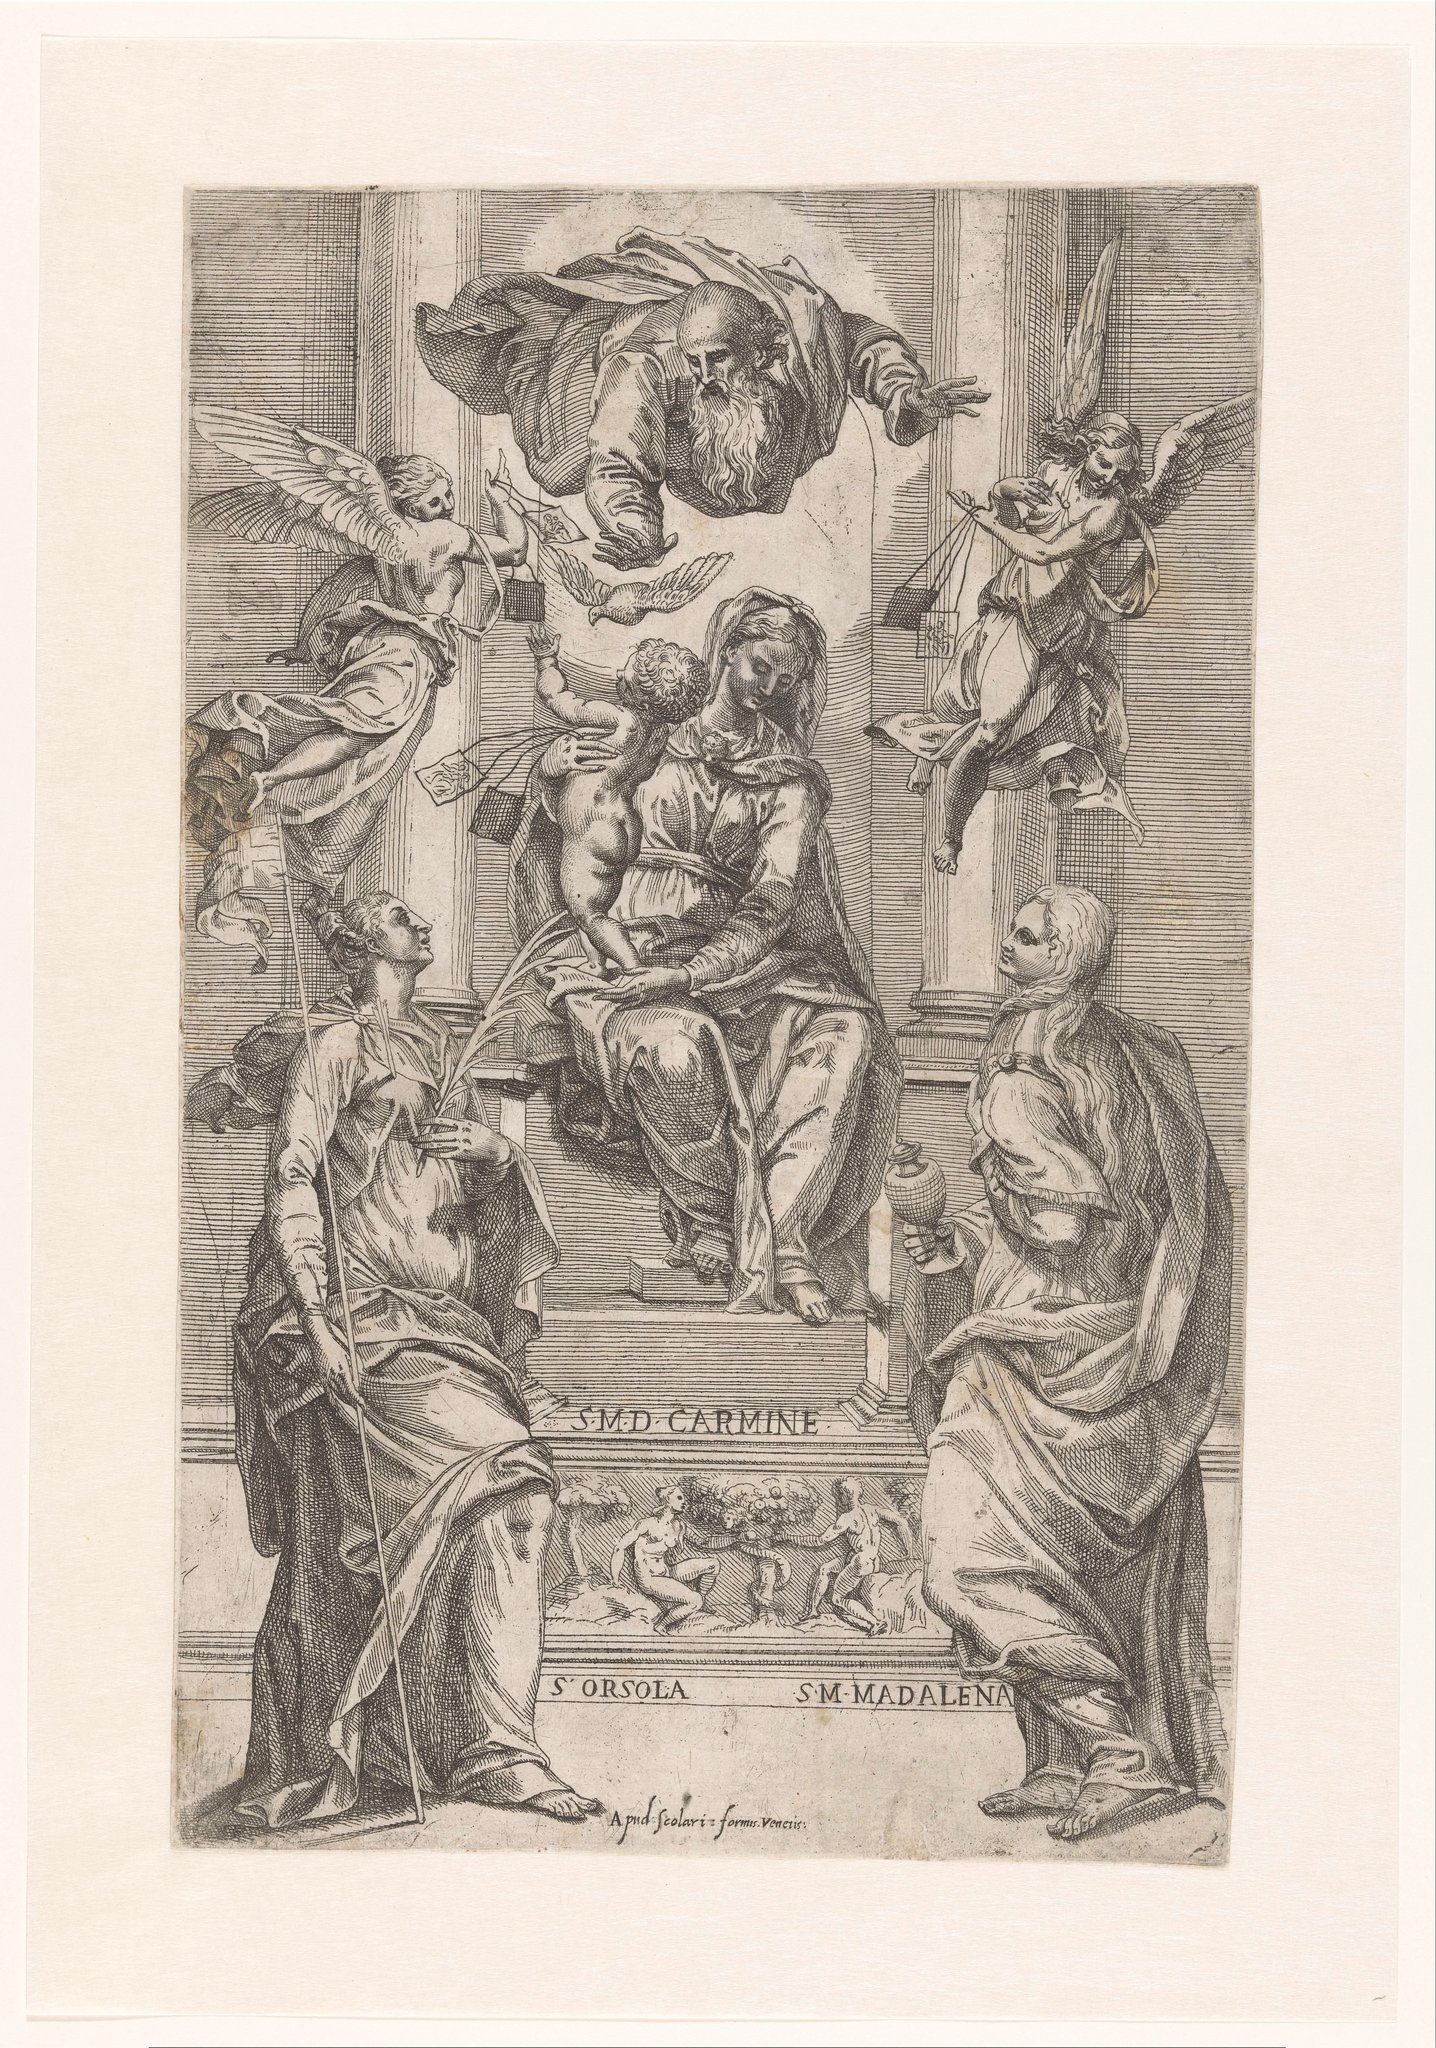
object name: print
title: Maria met Kind en de heiligen Ursula en Maria Magdalena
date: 1560-1580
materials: paper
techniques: engraving, intaglio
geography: venice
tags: the virgin martyr ursula of cologne; possible attributes: arrow, banner with red cross, cloak of ermine, crown, ship, madonna accompanied by saint(s), female saints (with name)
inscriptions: collector's mark: Lugt 2228, collector's mark: Lugt 2760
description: Getroonde Maria in een nis met het Christuskind op schoot, geflankeerd door twee engelen. Boven hen de Heilige Geest en God de Vader. Op de voorgrond de heilige Ursula met in haar hand een staf met banier en Maria Magdalena met de zalfpot. Onder de troon een gebeeldhouwd fries met een voorstelling van de Zondeval. Zowel de engelen als Maria houden aan touwtjes bevestigde bidprenten vast met daarop de voorstelling van Maria met het Christuskind.